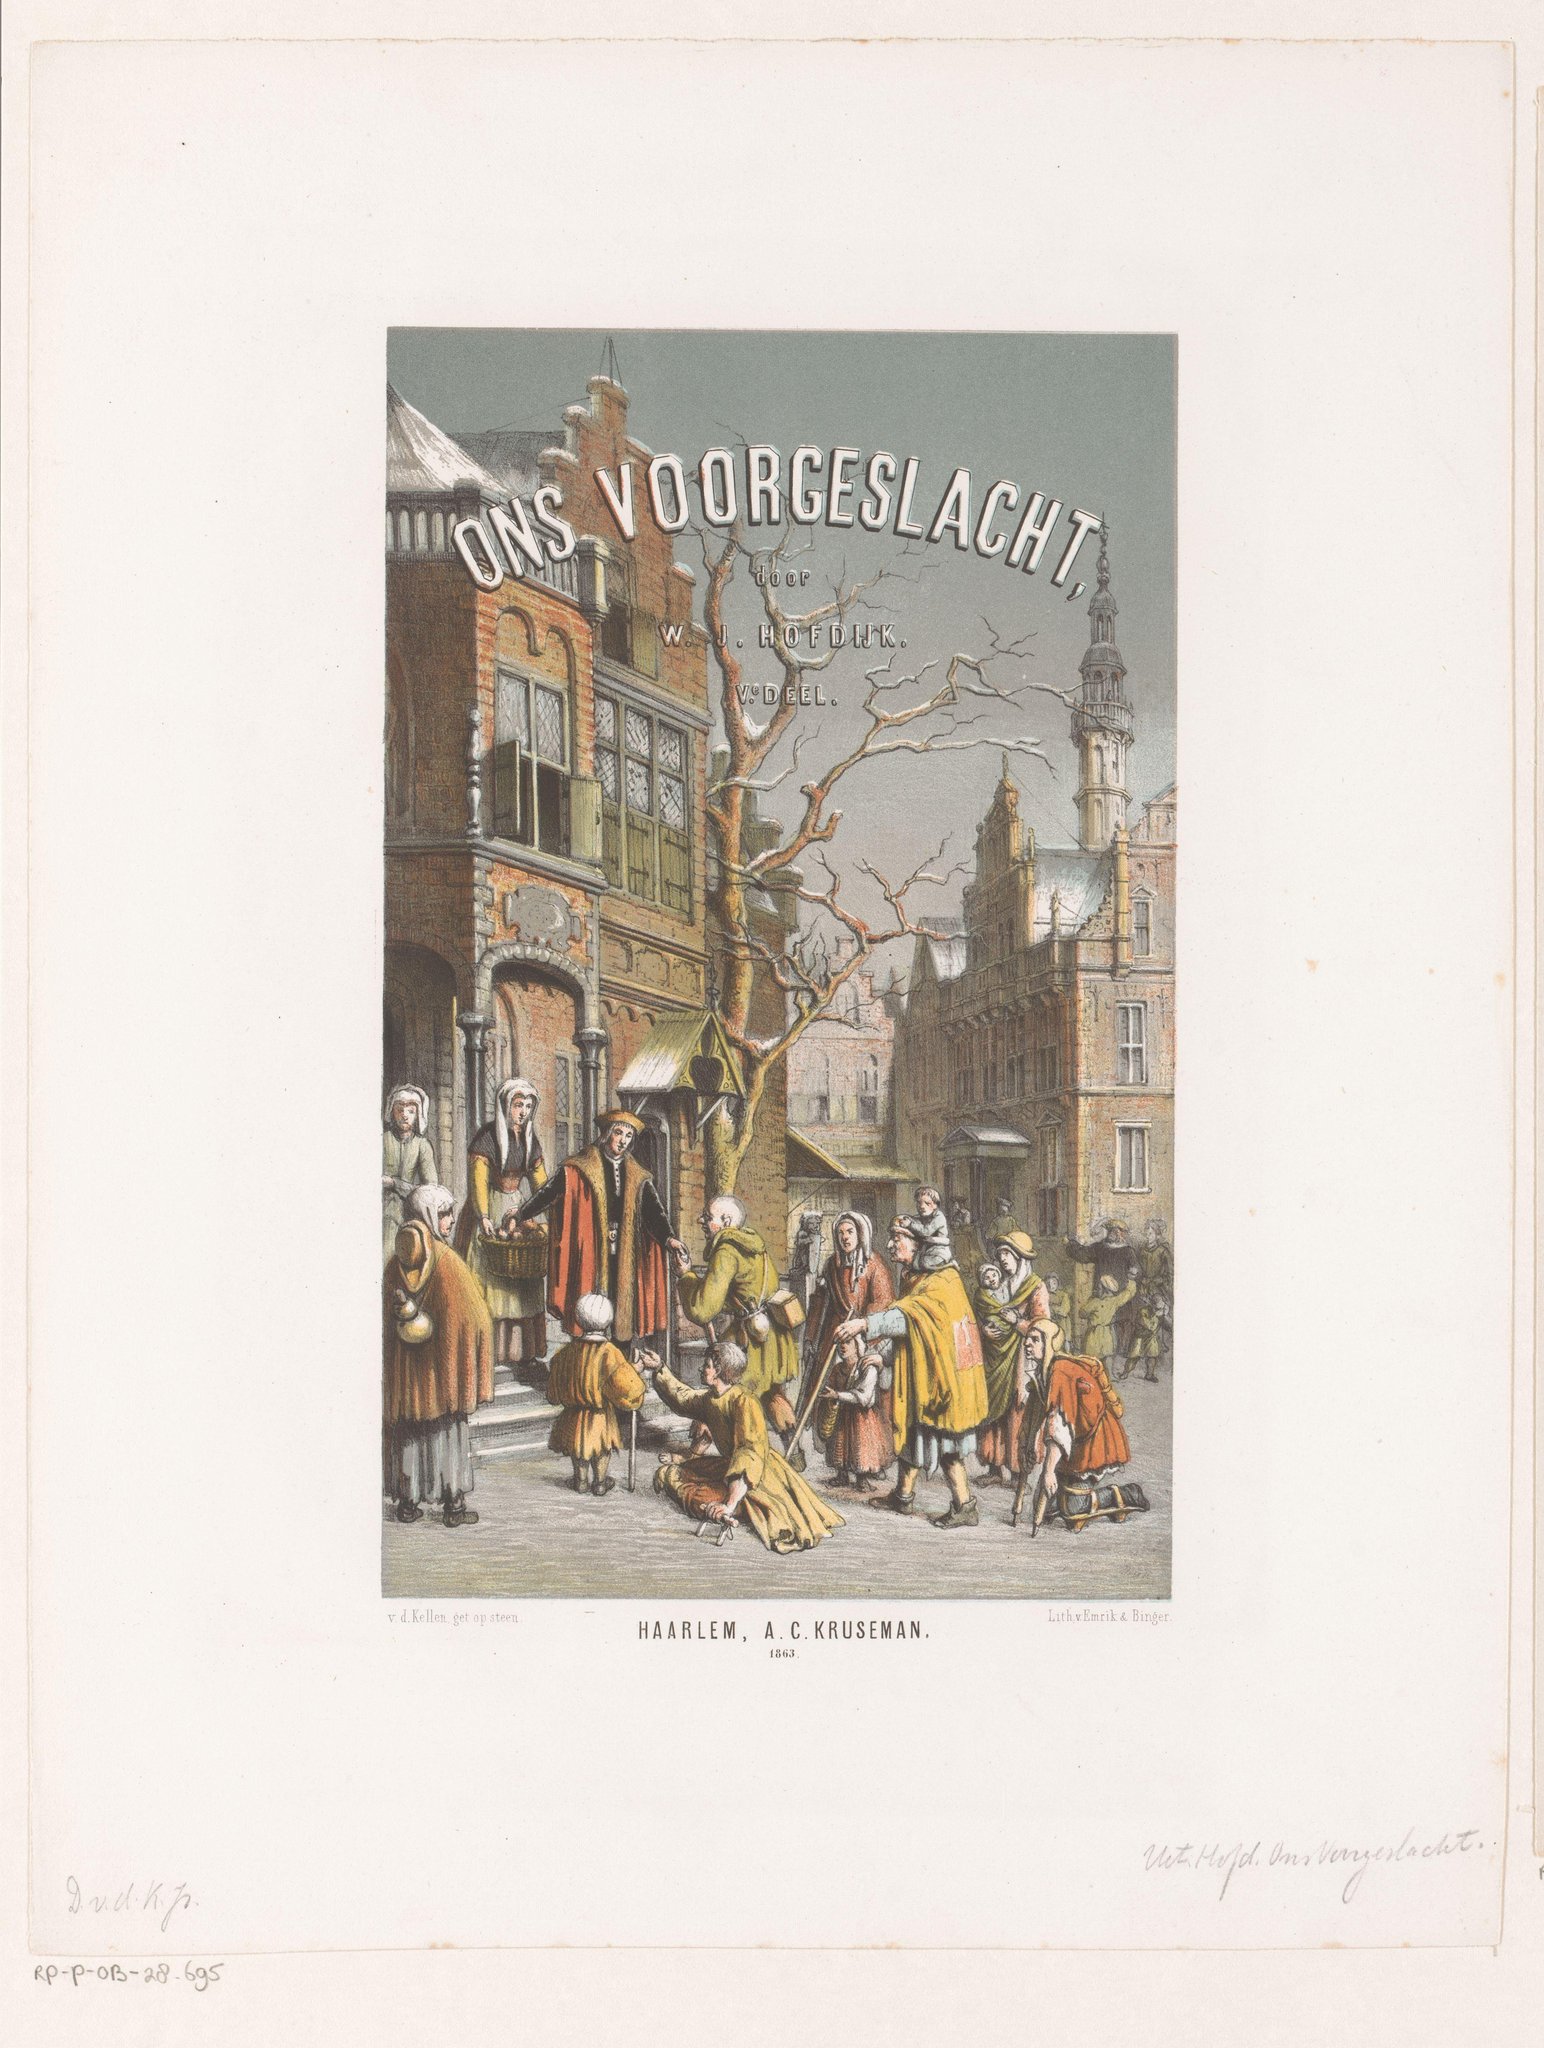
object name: titelblad, titelpagina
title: Ons Voorgeslacht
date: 1863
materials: paper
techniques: lithograph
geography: netherlands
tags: giving alms or other charity, e.g.: handing out food, person with a physical disability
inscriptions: collector's mark: Lugt 2228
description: Op de stoep van een huis deelt een man brood uit aan de armen. Enkelen van hen ondersteunen zichzelf met krukken.